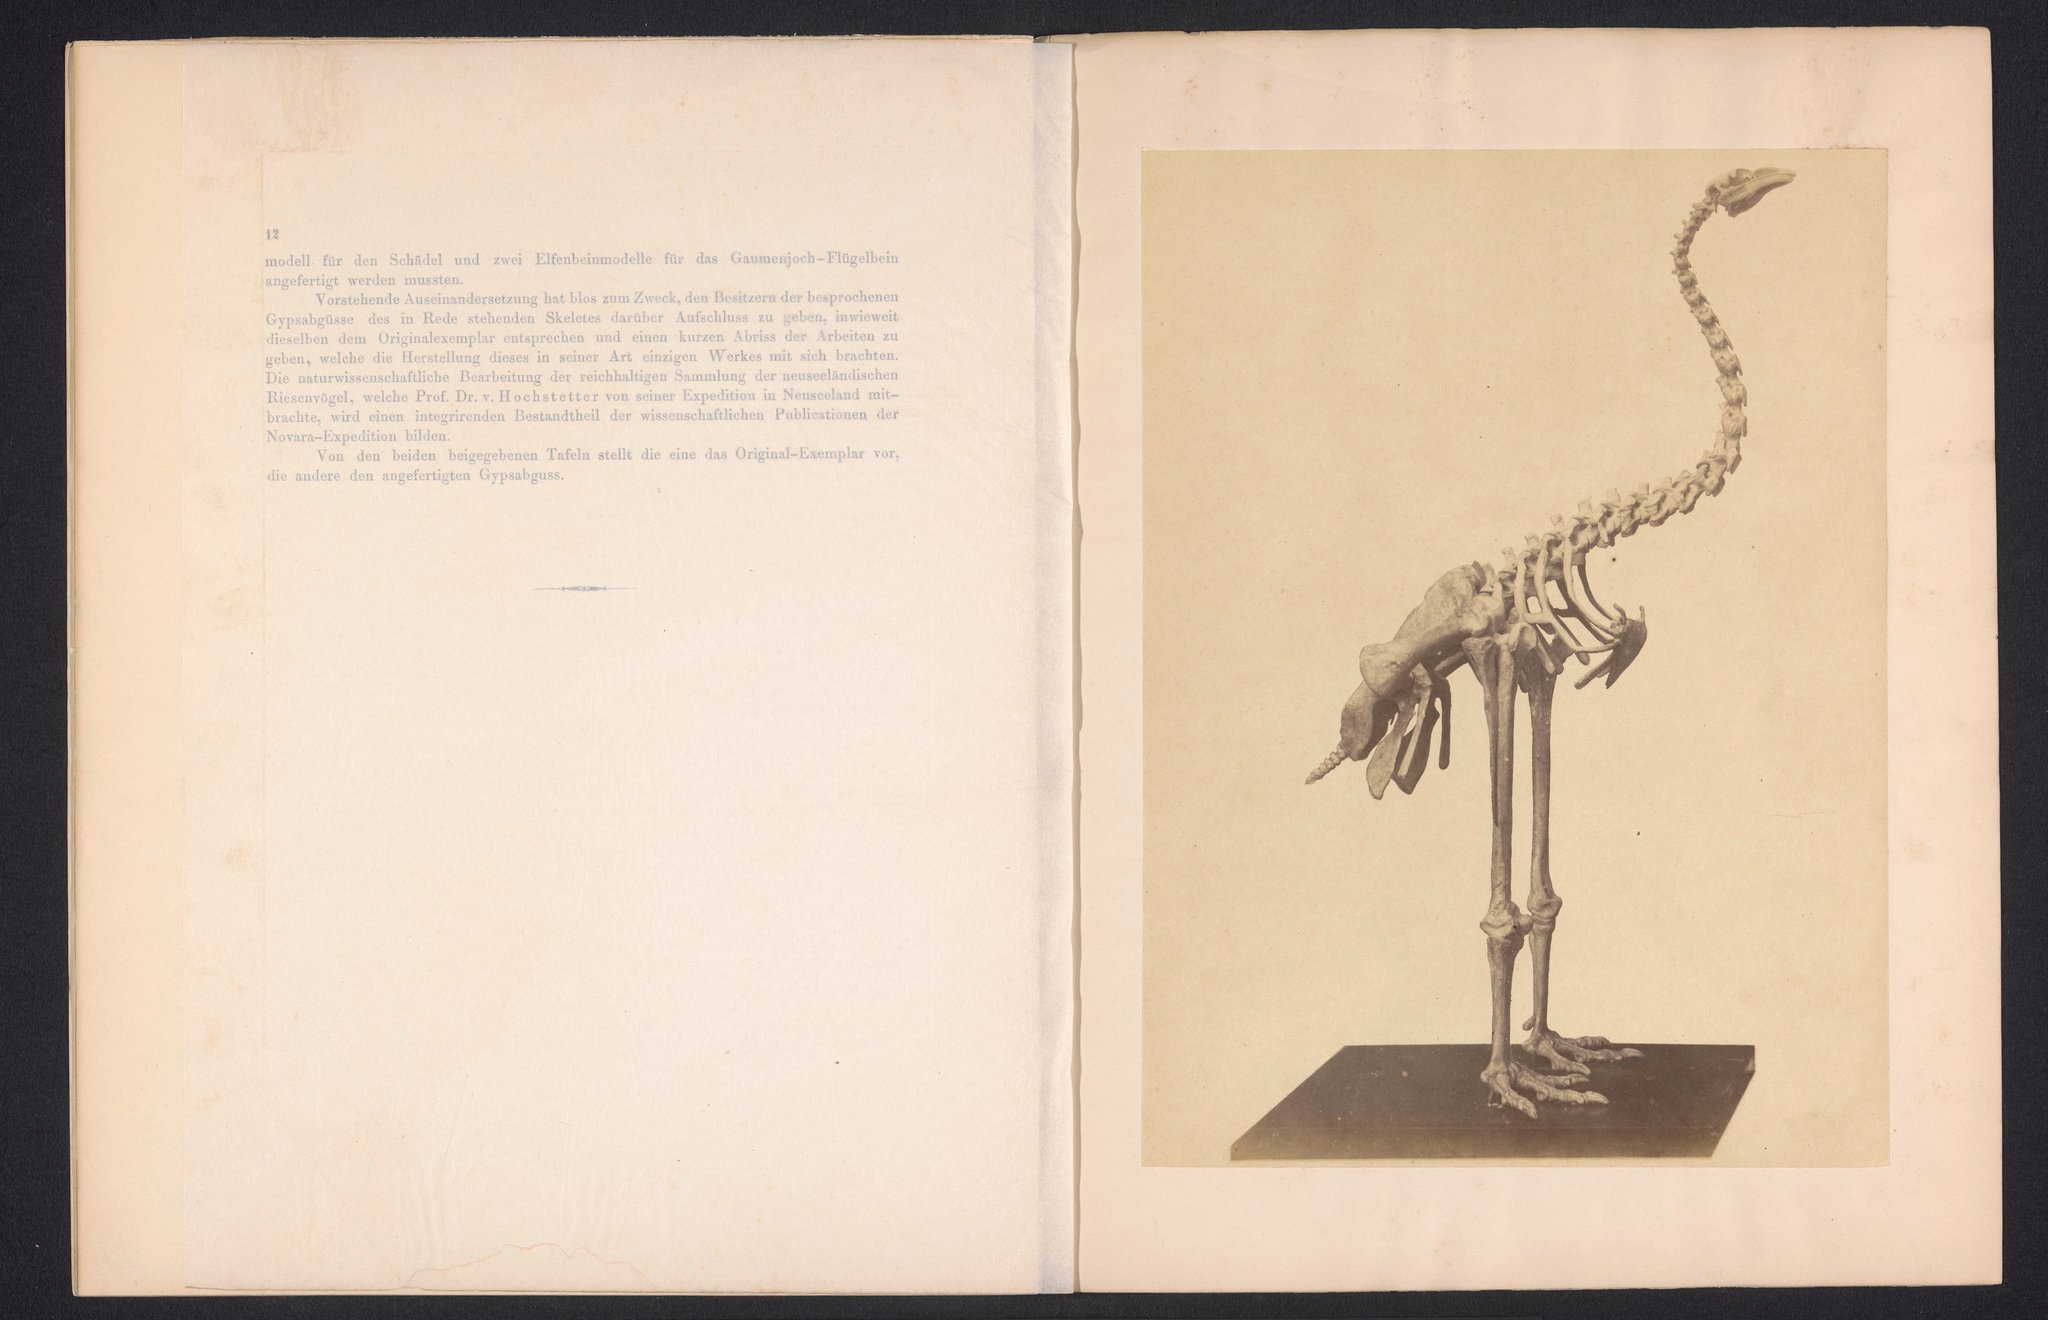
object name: page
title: Skelet van vermoedelijk een moa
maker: Anonymous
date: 1853-1863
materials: photographic support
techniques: albumen print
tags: walker and runner birds